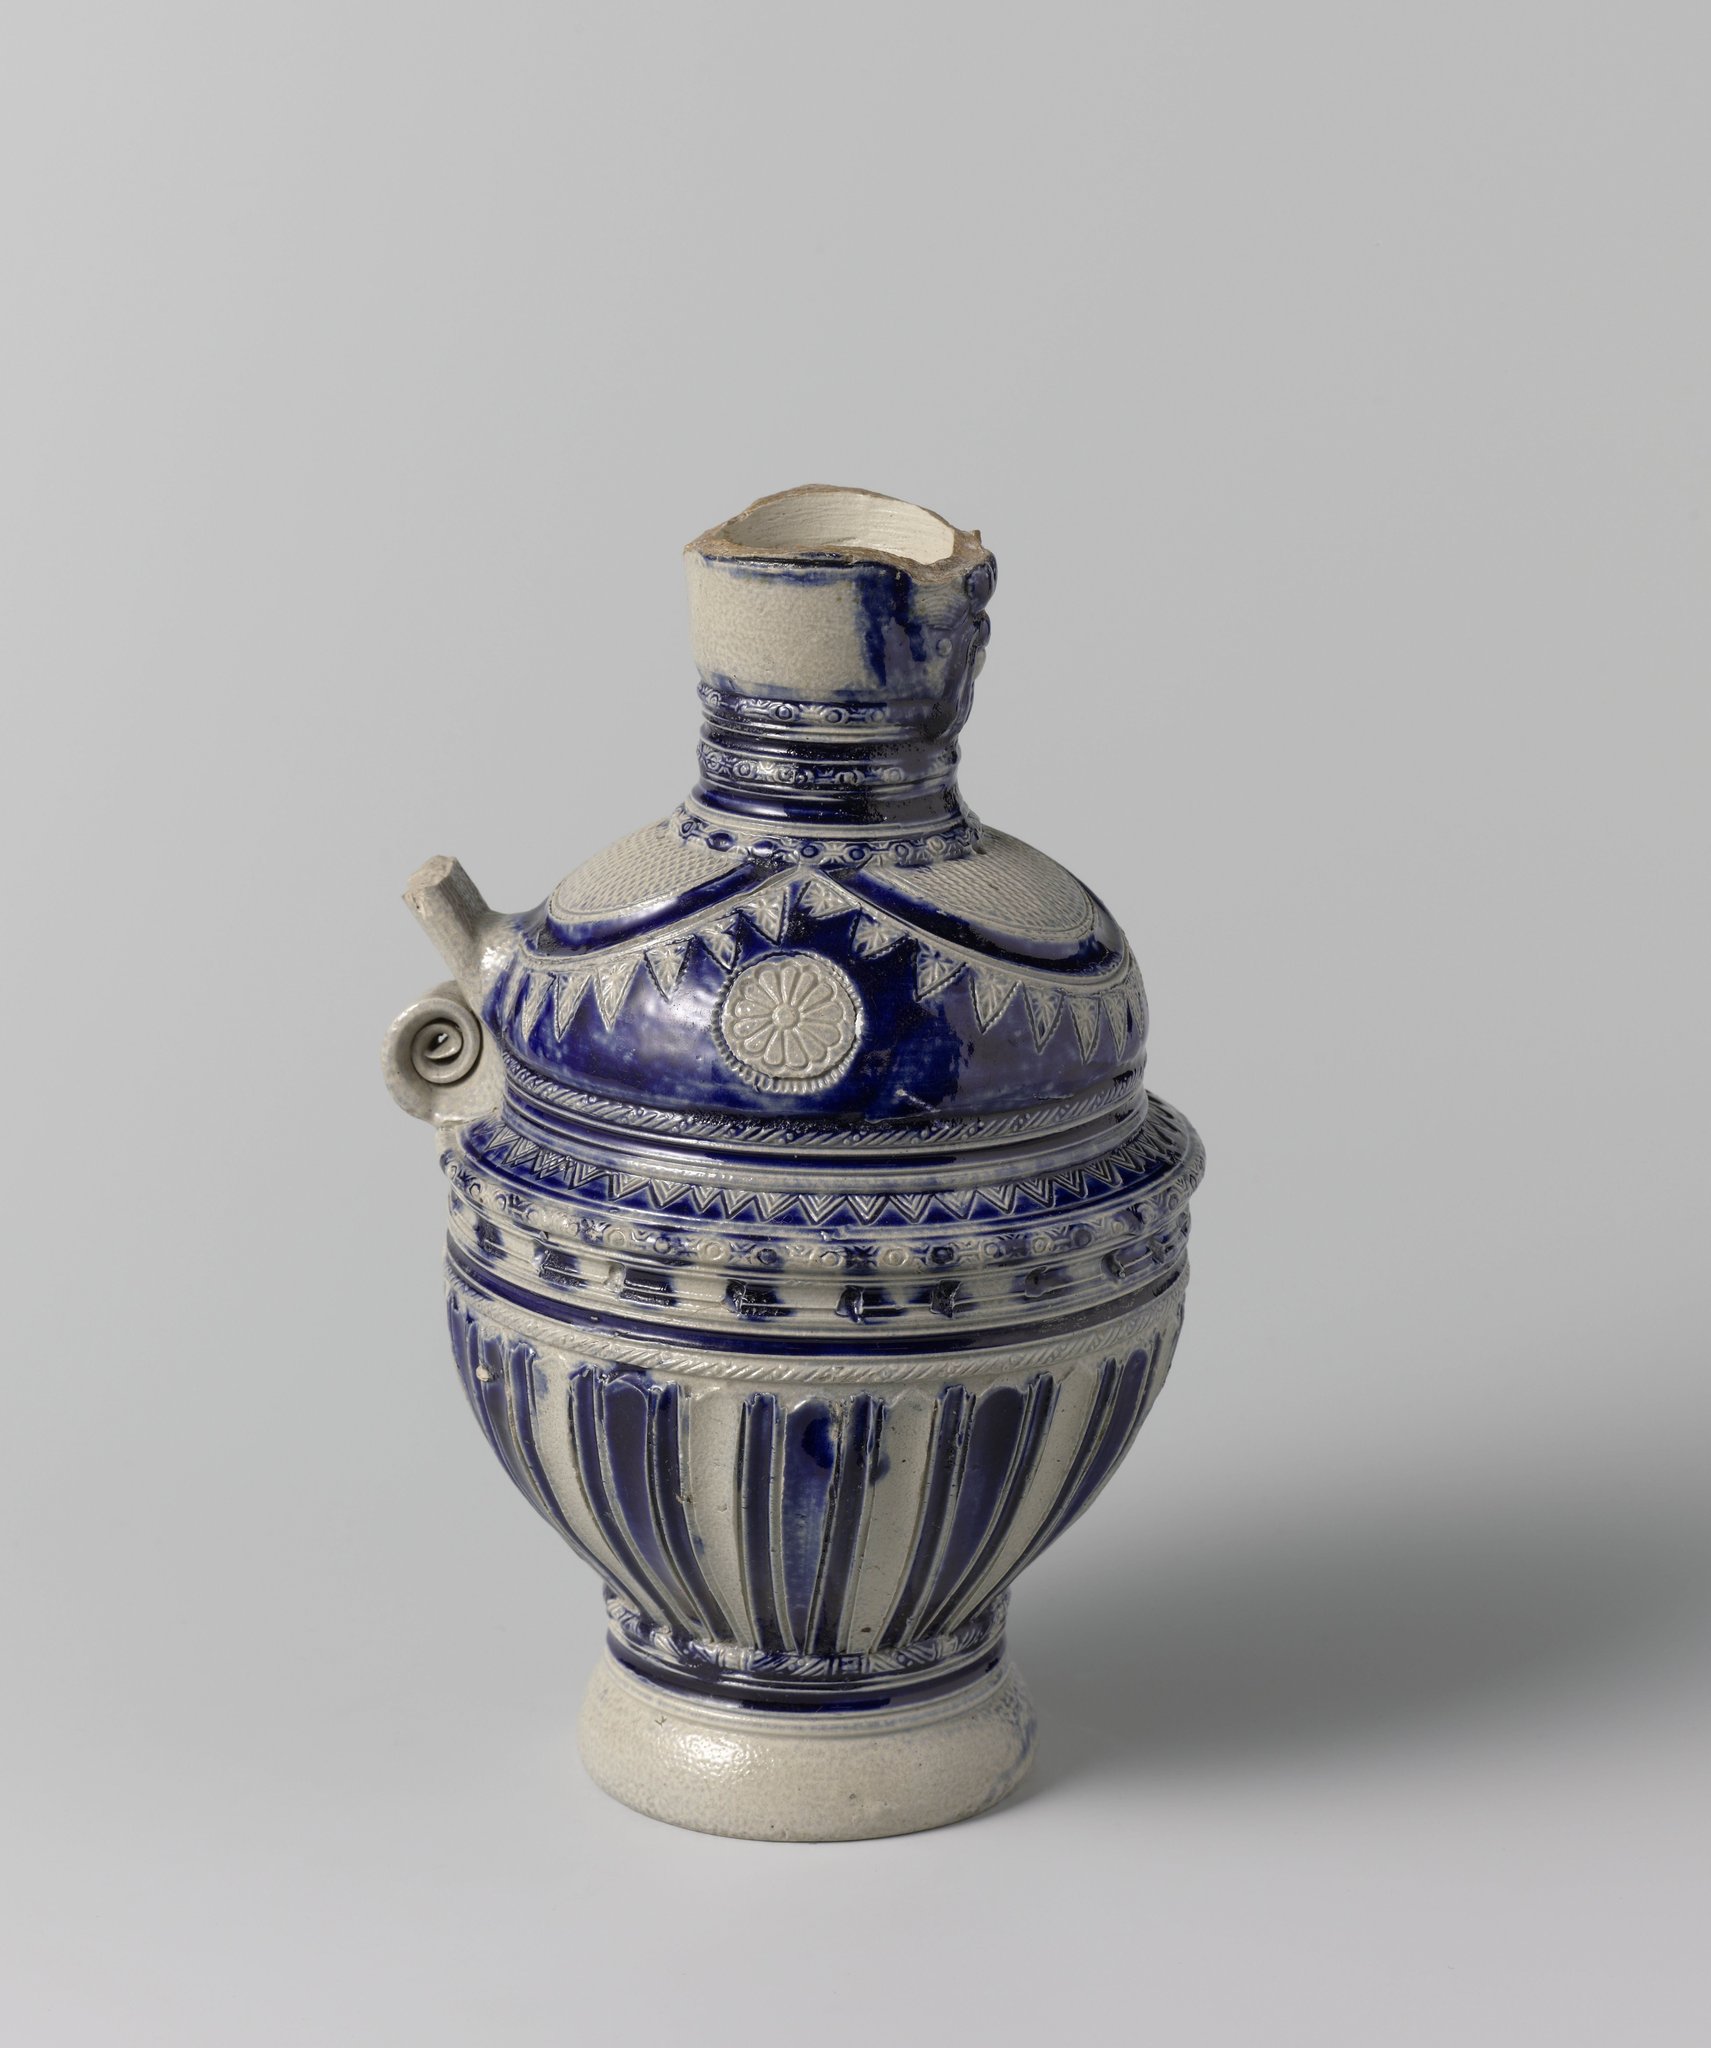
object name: ewer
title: Fragment of a jug with ornamental borders, flowers and a lion's head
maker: Anonymous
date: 1590-1620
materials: cobalt, glaze, stoneware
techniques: printing, firing, forming, relief, turning, vitrification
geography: raeren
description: Fragment van een kan van steengoed op hoge voet met een eivormig lichaam en smalle nek. Rand en oor ontbreken. Het oor (afgebroken) is bevestigd aan de schouder. Profielen op de nek, buik en voet. Gedeeltelijk bedekt met kobaltblauw. Het onderste deel van de buik met verticale canelures en het breedste deel met profielen en ingegrifte decoratie. De gewelfde schouder is iets smaller dan de buik en gedecoreerd met halfronde vakken met kerfsnede omringd door gedrukte driehoeken en rozetten. Op de nek in reliëf een gedrukte en opgelegde leeuwenkop. Raeren/Westerwald.